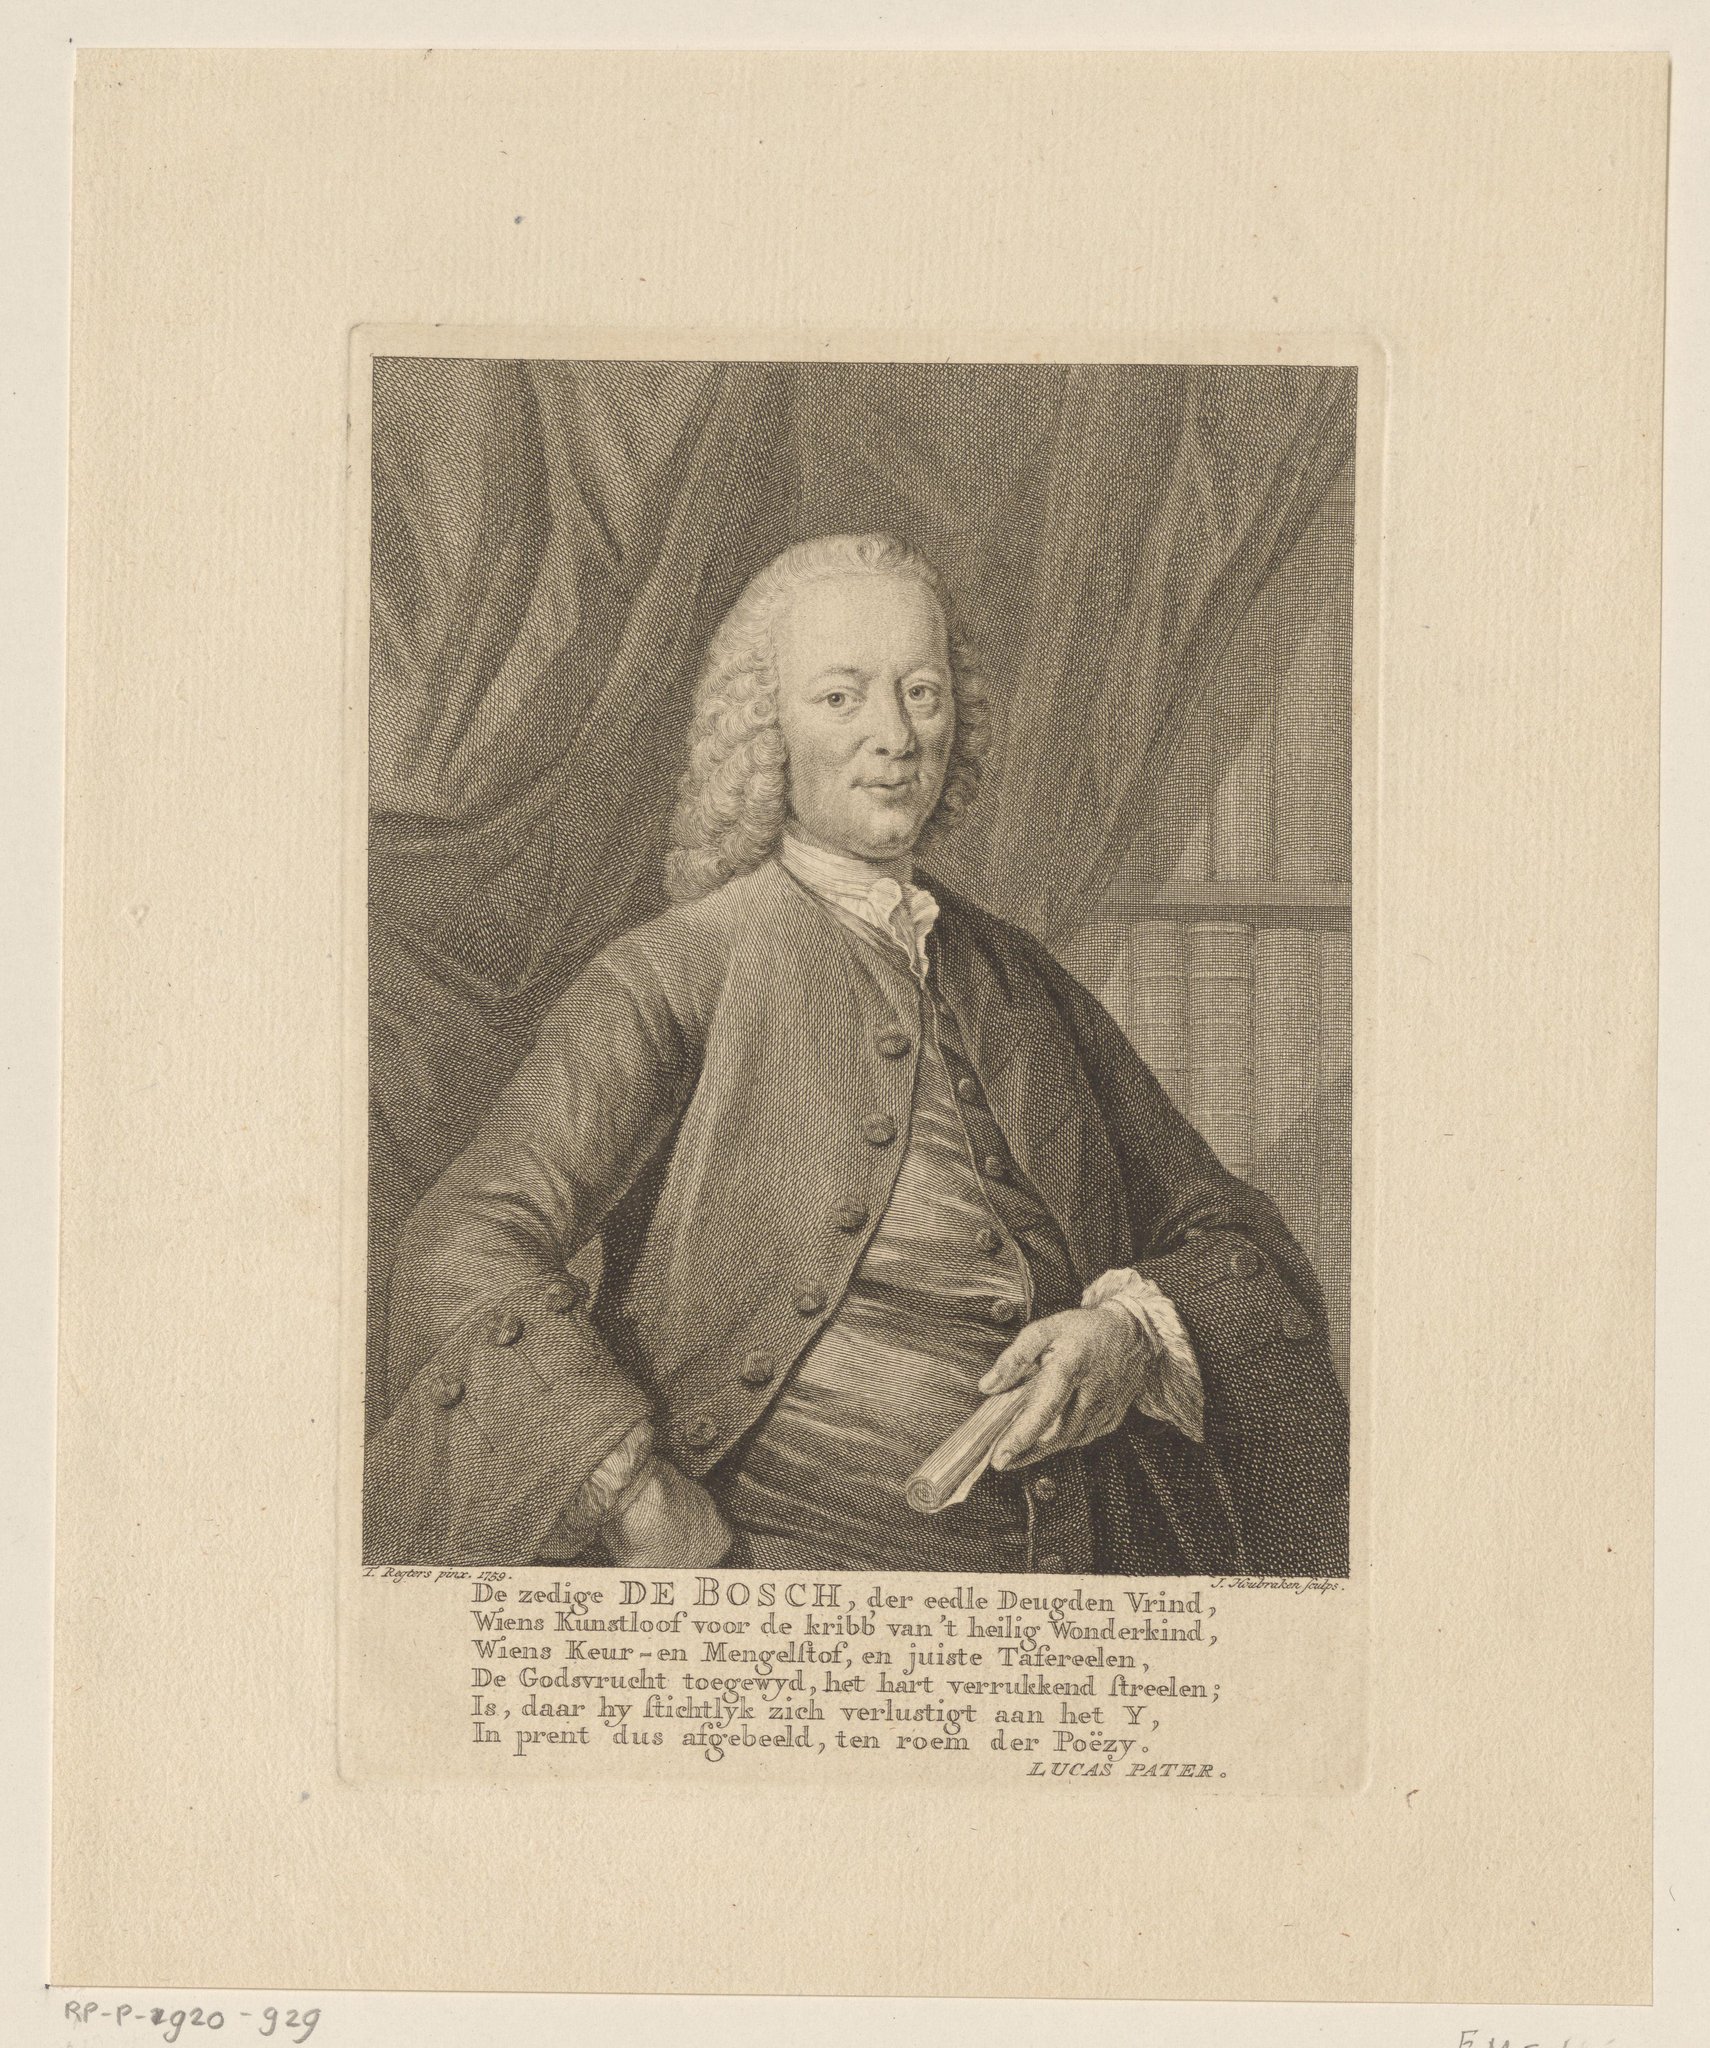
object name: print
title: Portret van Bernardus de Bosch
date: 1759-1780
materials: paper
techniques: engraving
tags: amsterdam, bernardus de bosch (schrijver), bookshelves, historical persons, portrait of a writer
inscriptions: collector's mark: Lugt 2228